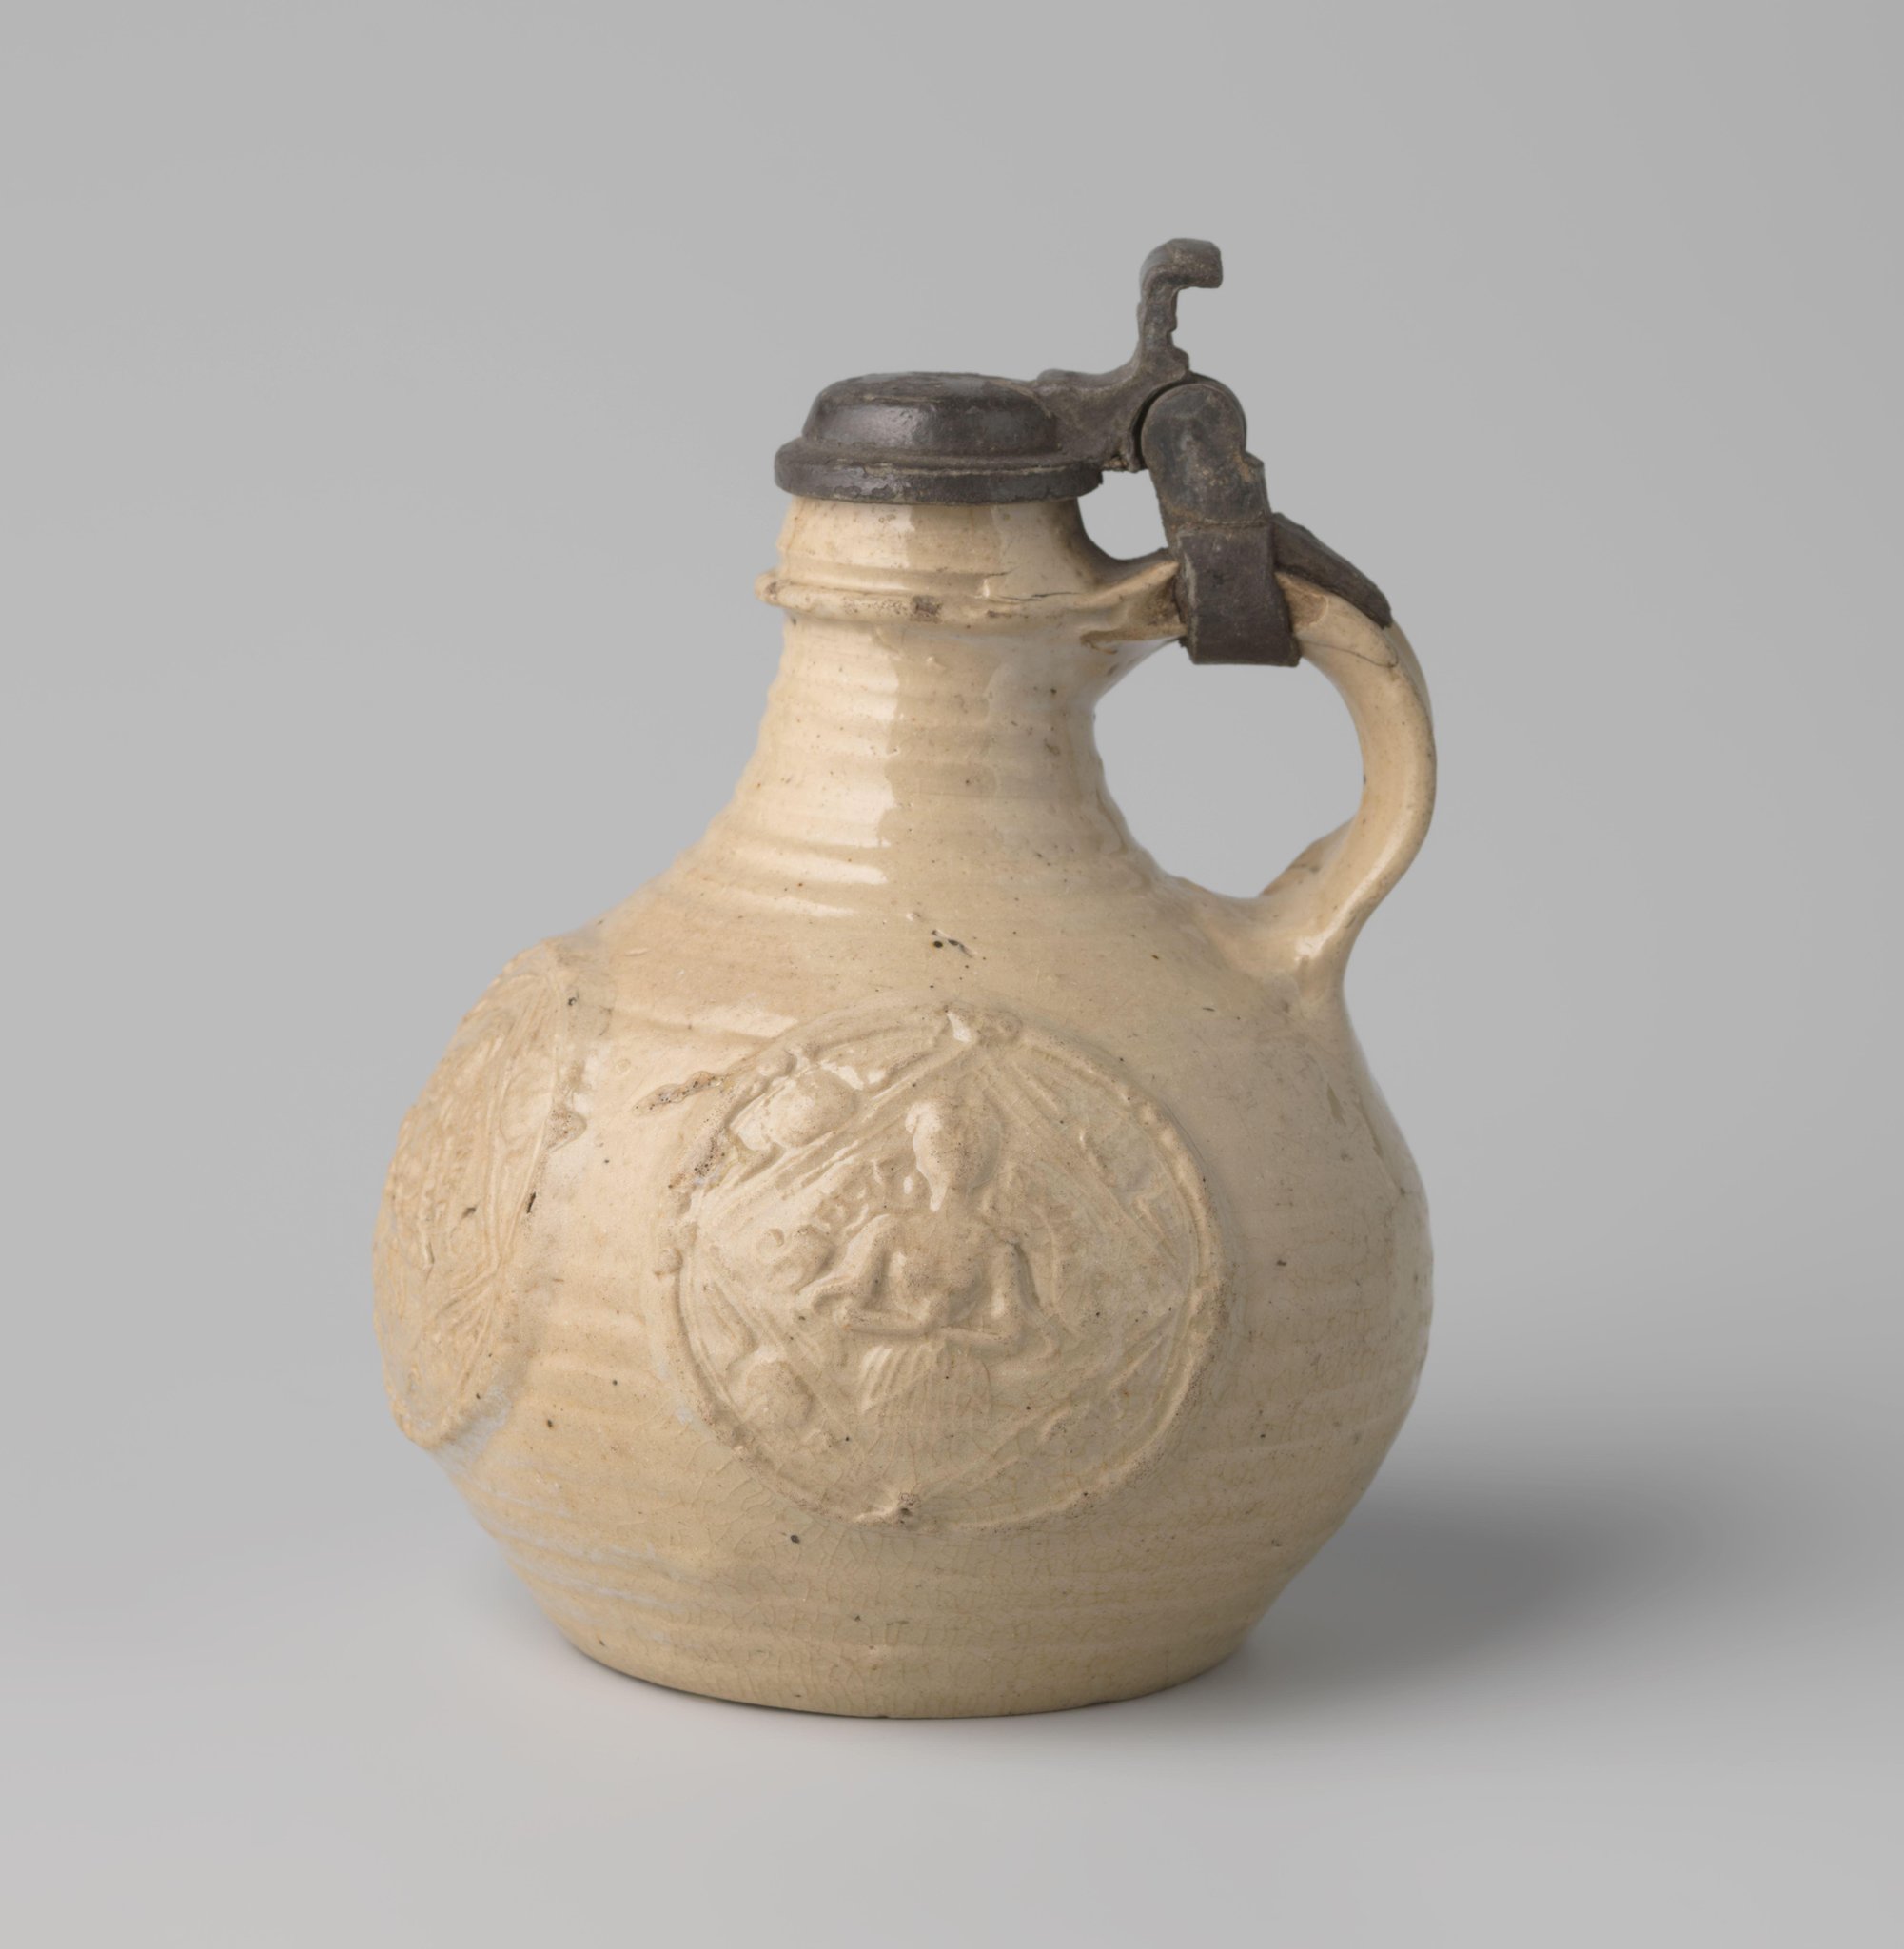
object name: jug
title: Jug with a personification of Hope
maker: anno knütgen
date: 1560-1580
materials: glaze, stoneware, tin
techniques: firing, forming, relief, turning, vitrification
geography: siegburg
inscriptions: inscription: ‘HOFNUNG’, mark: ‘C.I.’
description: Kruik van steengoed op standring met een bolvormig lichaam en smalle nek. Het C-vormige oor is bevestigd aan de nek en de schouder. Profiel op de nek. De kruik is versierd met draairingen, waarbij de schouder is gladgestreken. Op de buik in reliëf driemaal een gedrukt en opgelegd medaillon met de personificatie van de Hoop met het opschrift 'HOFNUNG'. De rand van het medaillon met vier engelenkoppen. Bevestigd aan het oor een tinnen montuur met deksel; aan de binnenzijde gemerkt met een kroon en de letters 'C.I.'. Siegburg.